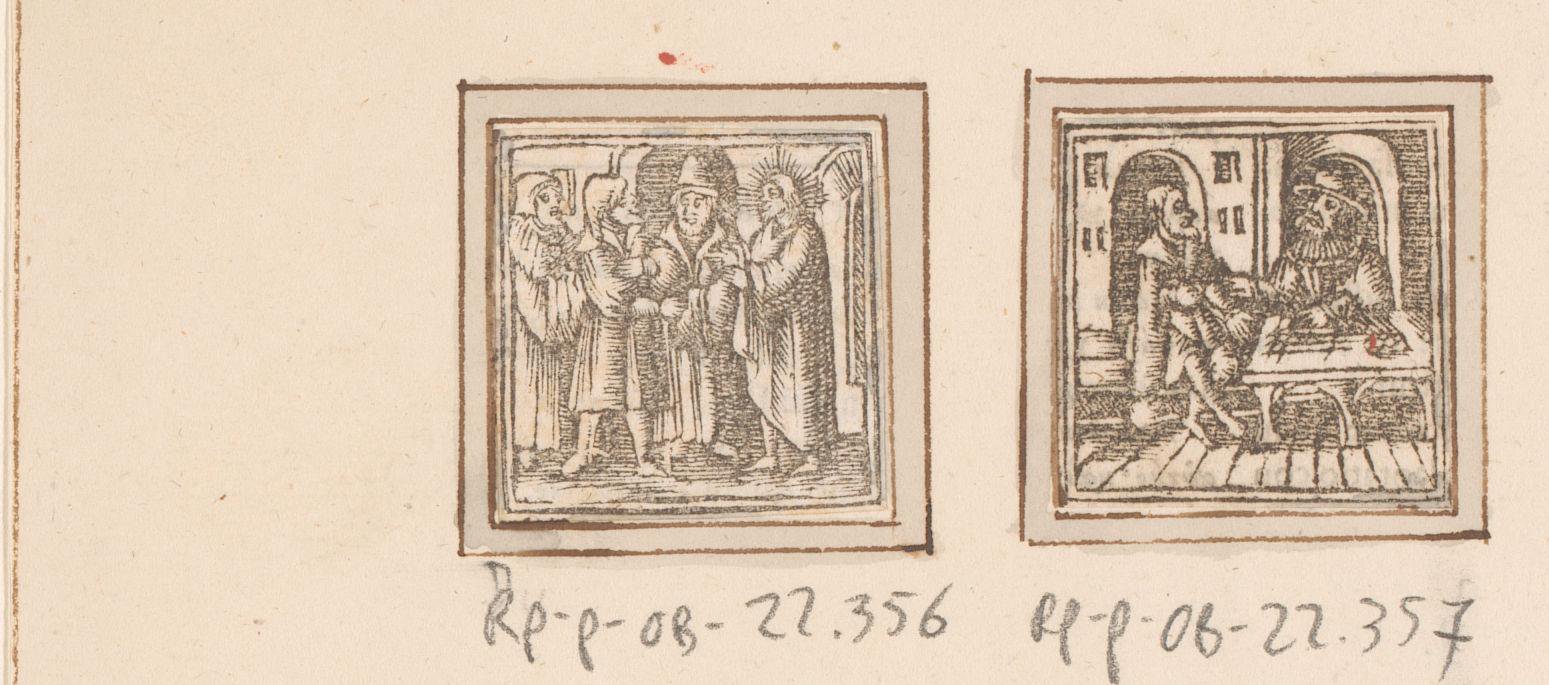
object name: book illustration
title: Christus sprekend met Joden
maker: Anonymous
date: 1590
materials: paper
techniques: woodcut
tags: christ preaching or teaching (in general)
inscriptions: collector's mark: Lugt 240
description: Prent afkomstig uit een onbekende Latijnse bijbel, mogelijk gedateerd 1590.